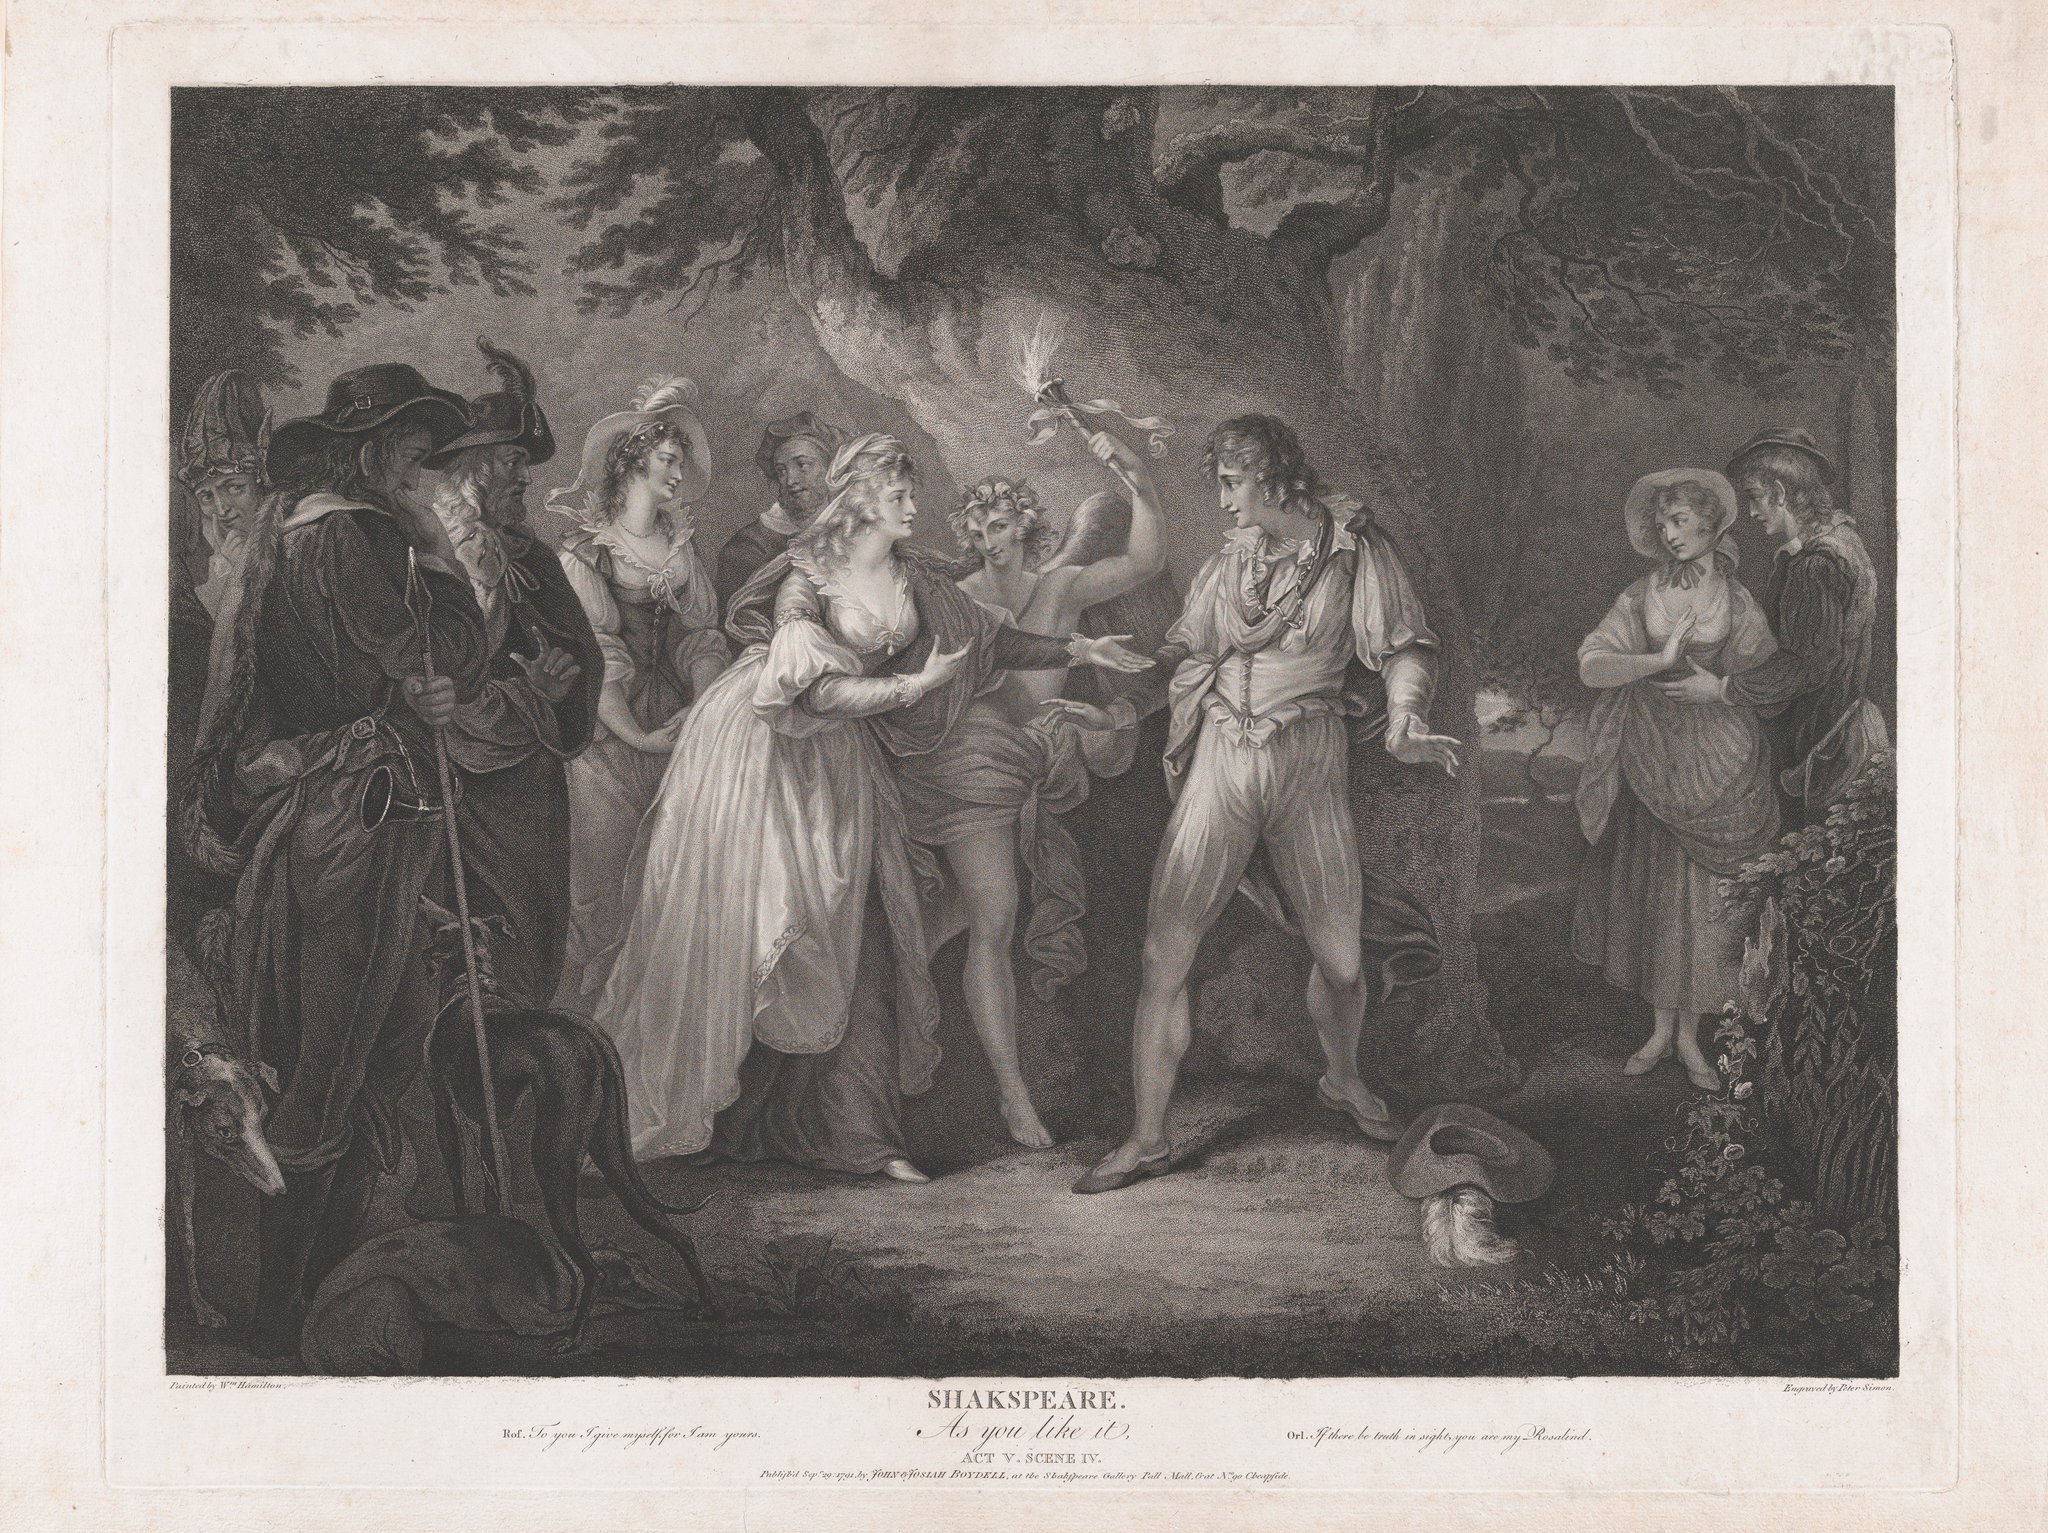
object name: print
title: "To you I give myself, for I am yours" (Shakespeare, As You Like It, Act 5, Scene 4)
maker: peter simon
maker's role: engraver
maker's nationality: british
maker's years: 1764-1813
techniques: engraving, etching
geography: england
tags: shakespeare,men,women